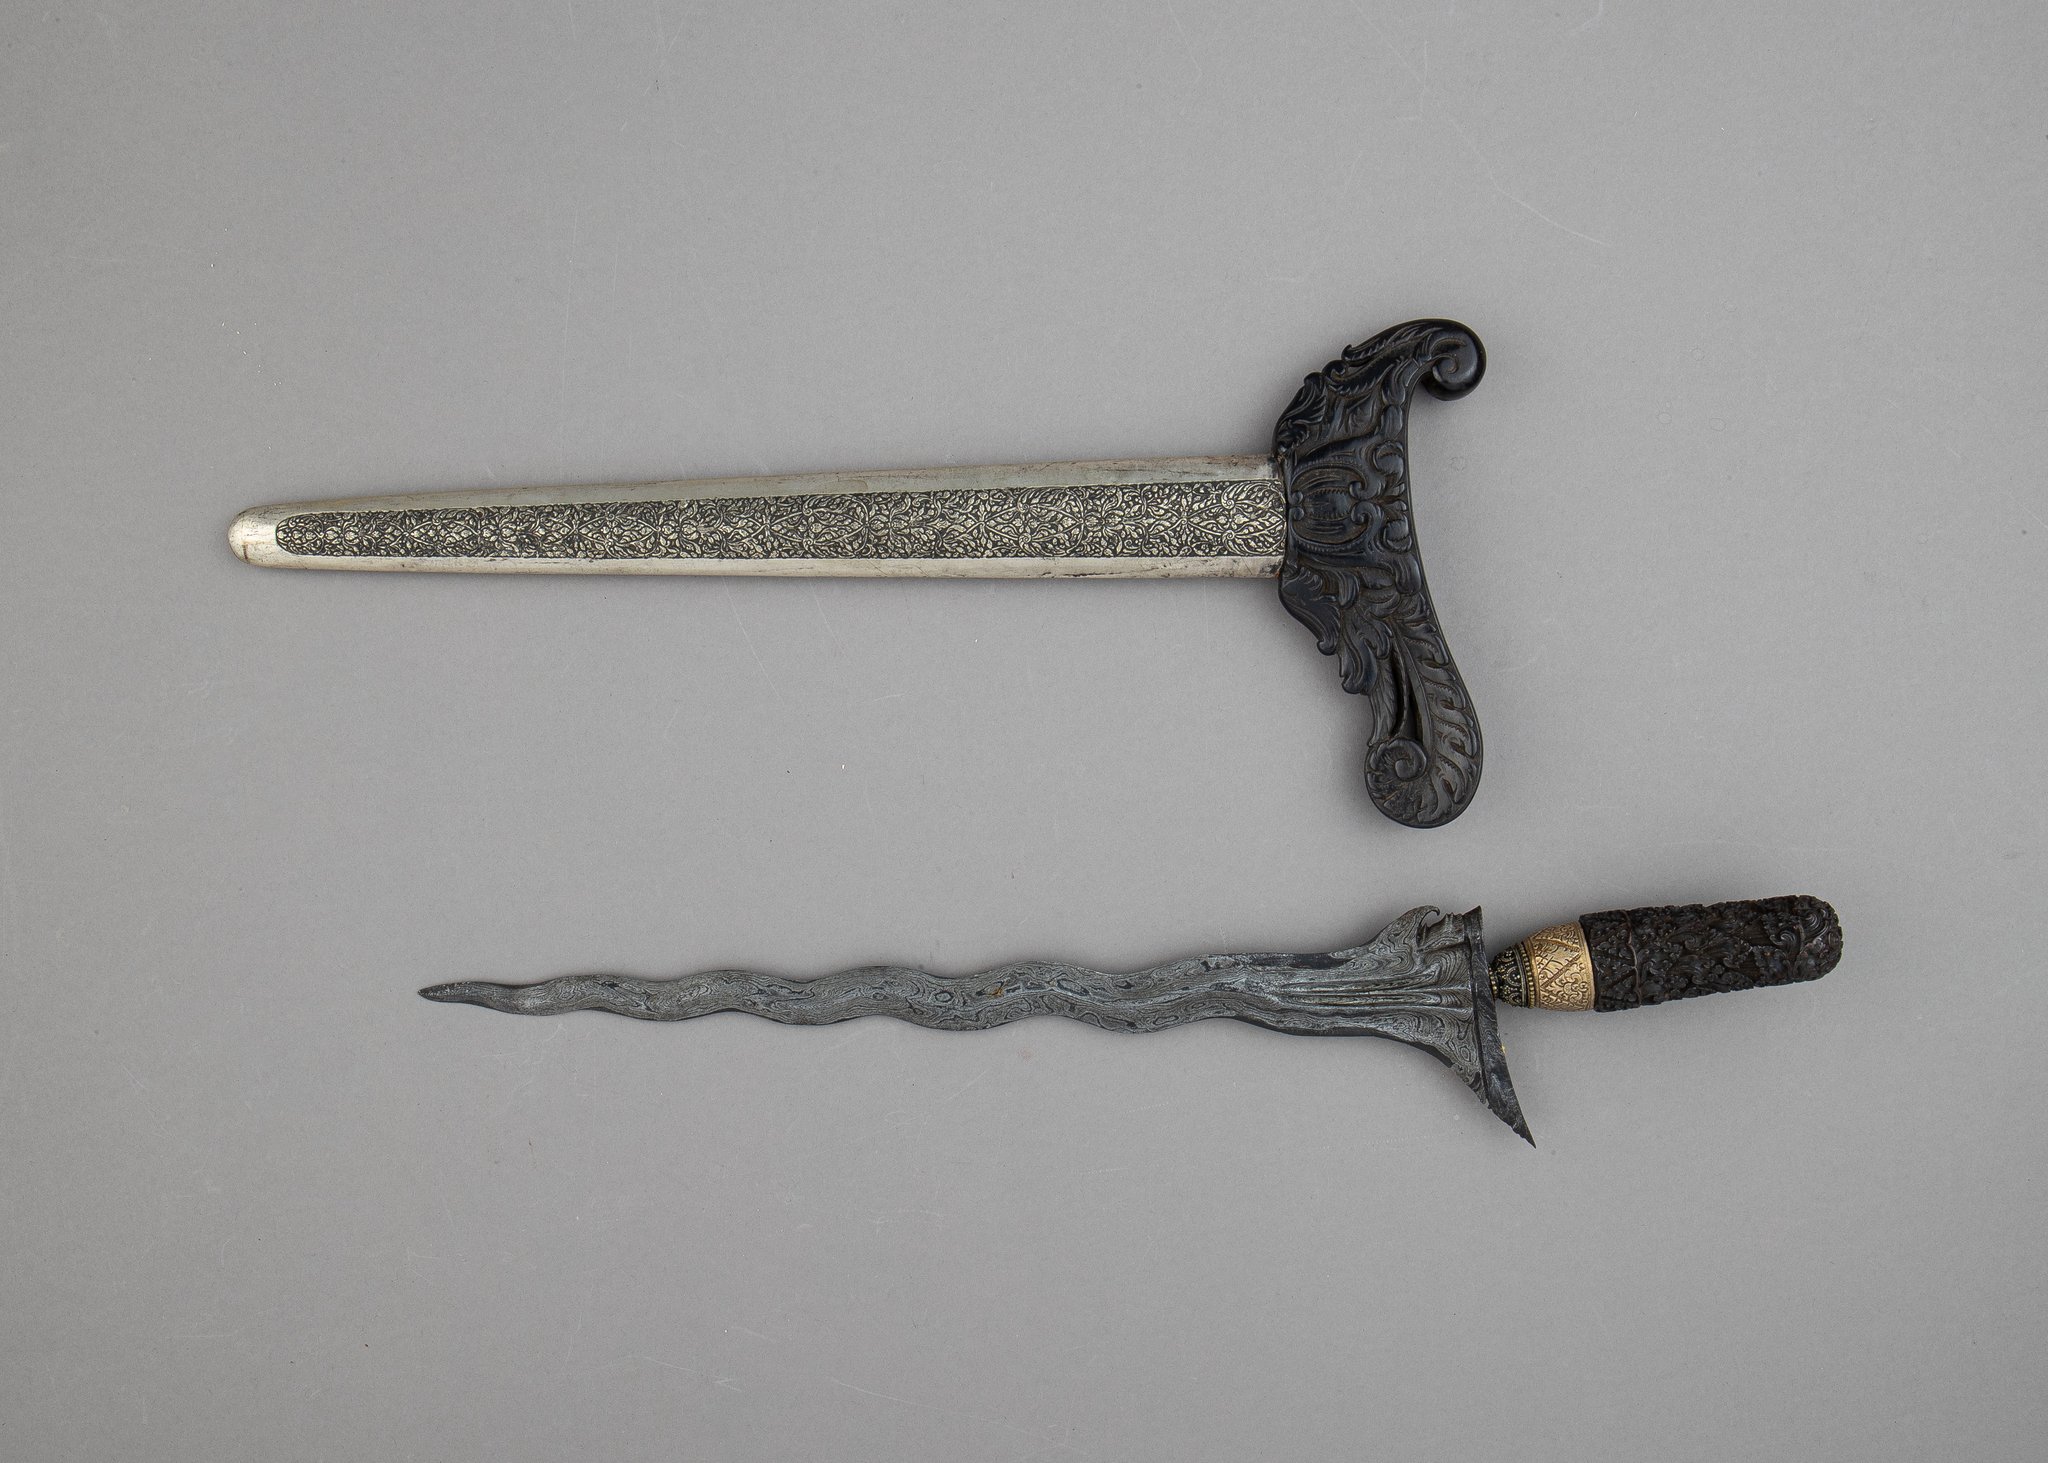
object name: kris with sheath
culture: madurese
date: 1501-1900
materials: brass, silver, steel, wood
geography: indonesia